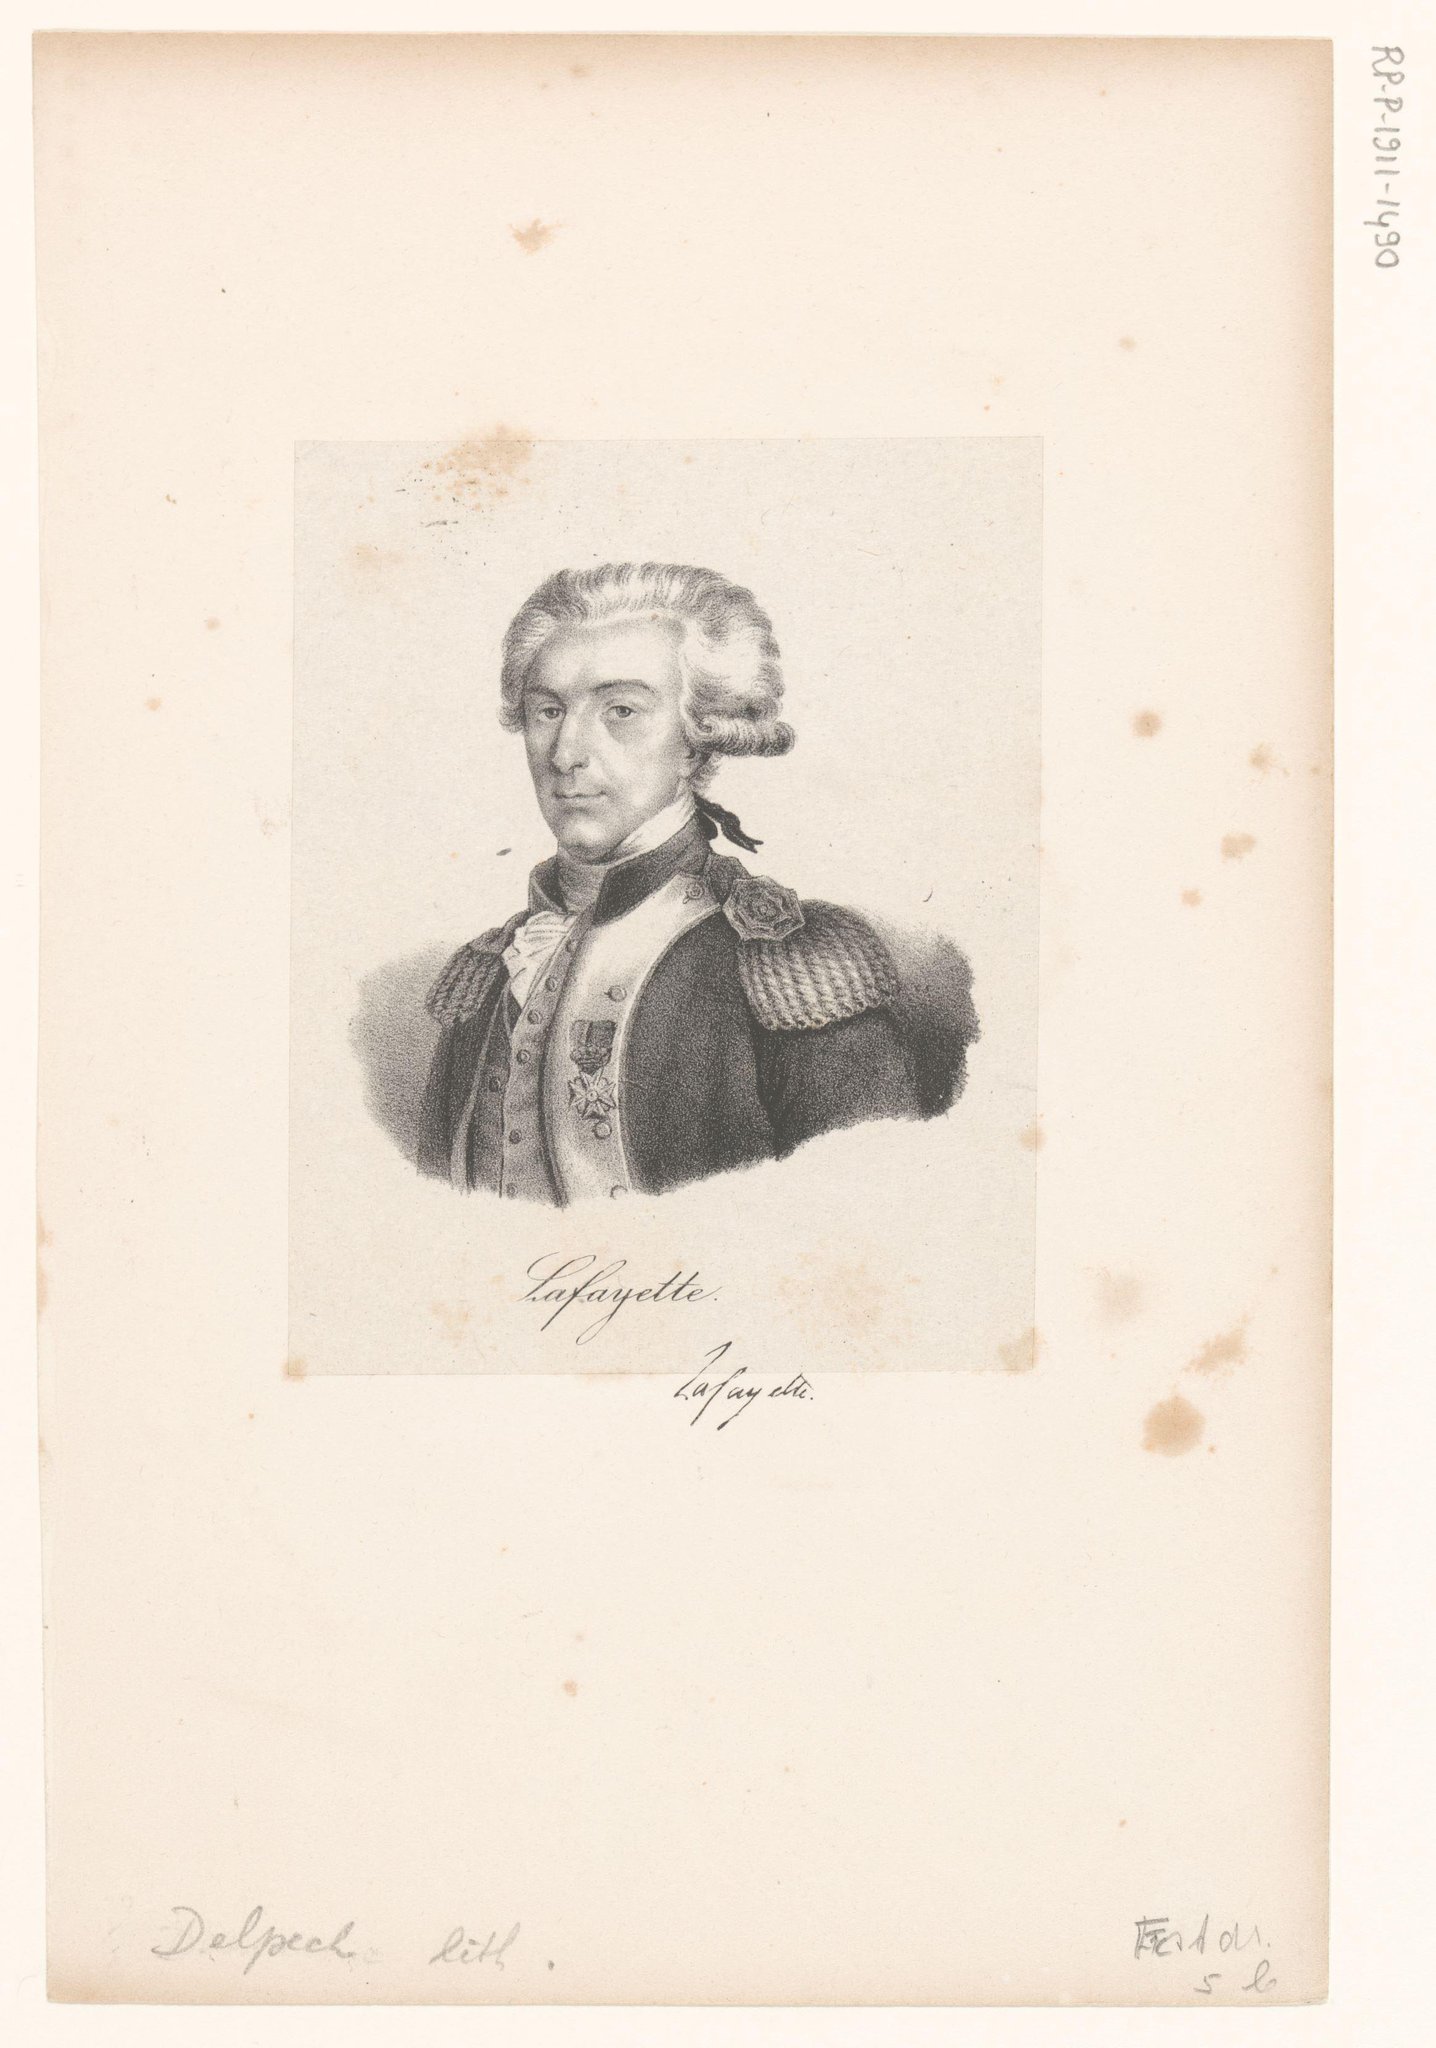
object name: print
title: Lafayette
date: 1818-1842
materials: paper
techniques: lithograph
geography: paris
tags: paris, politician, historical persons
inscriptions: collector's mark: Lugt 2228a